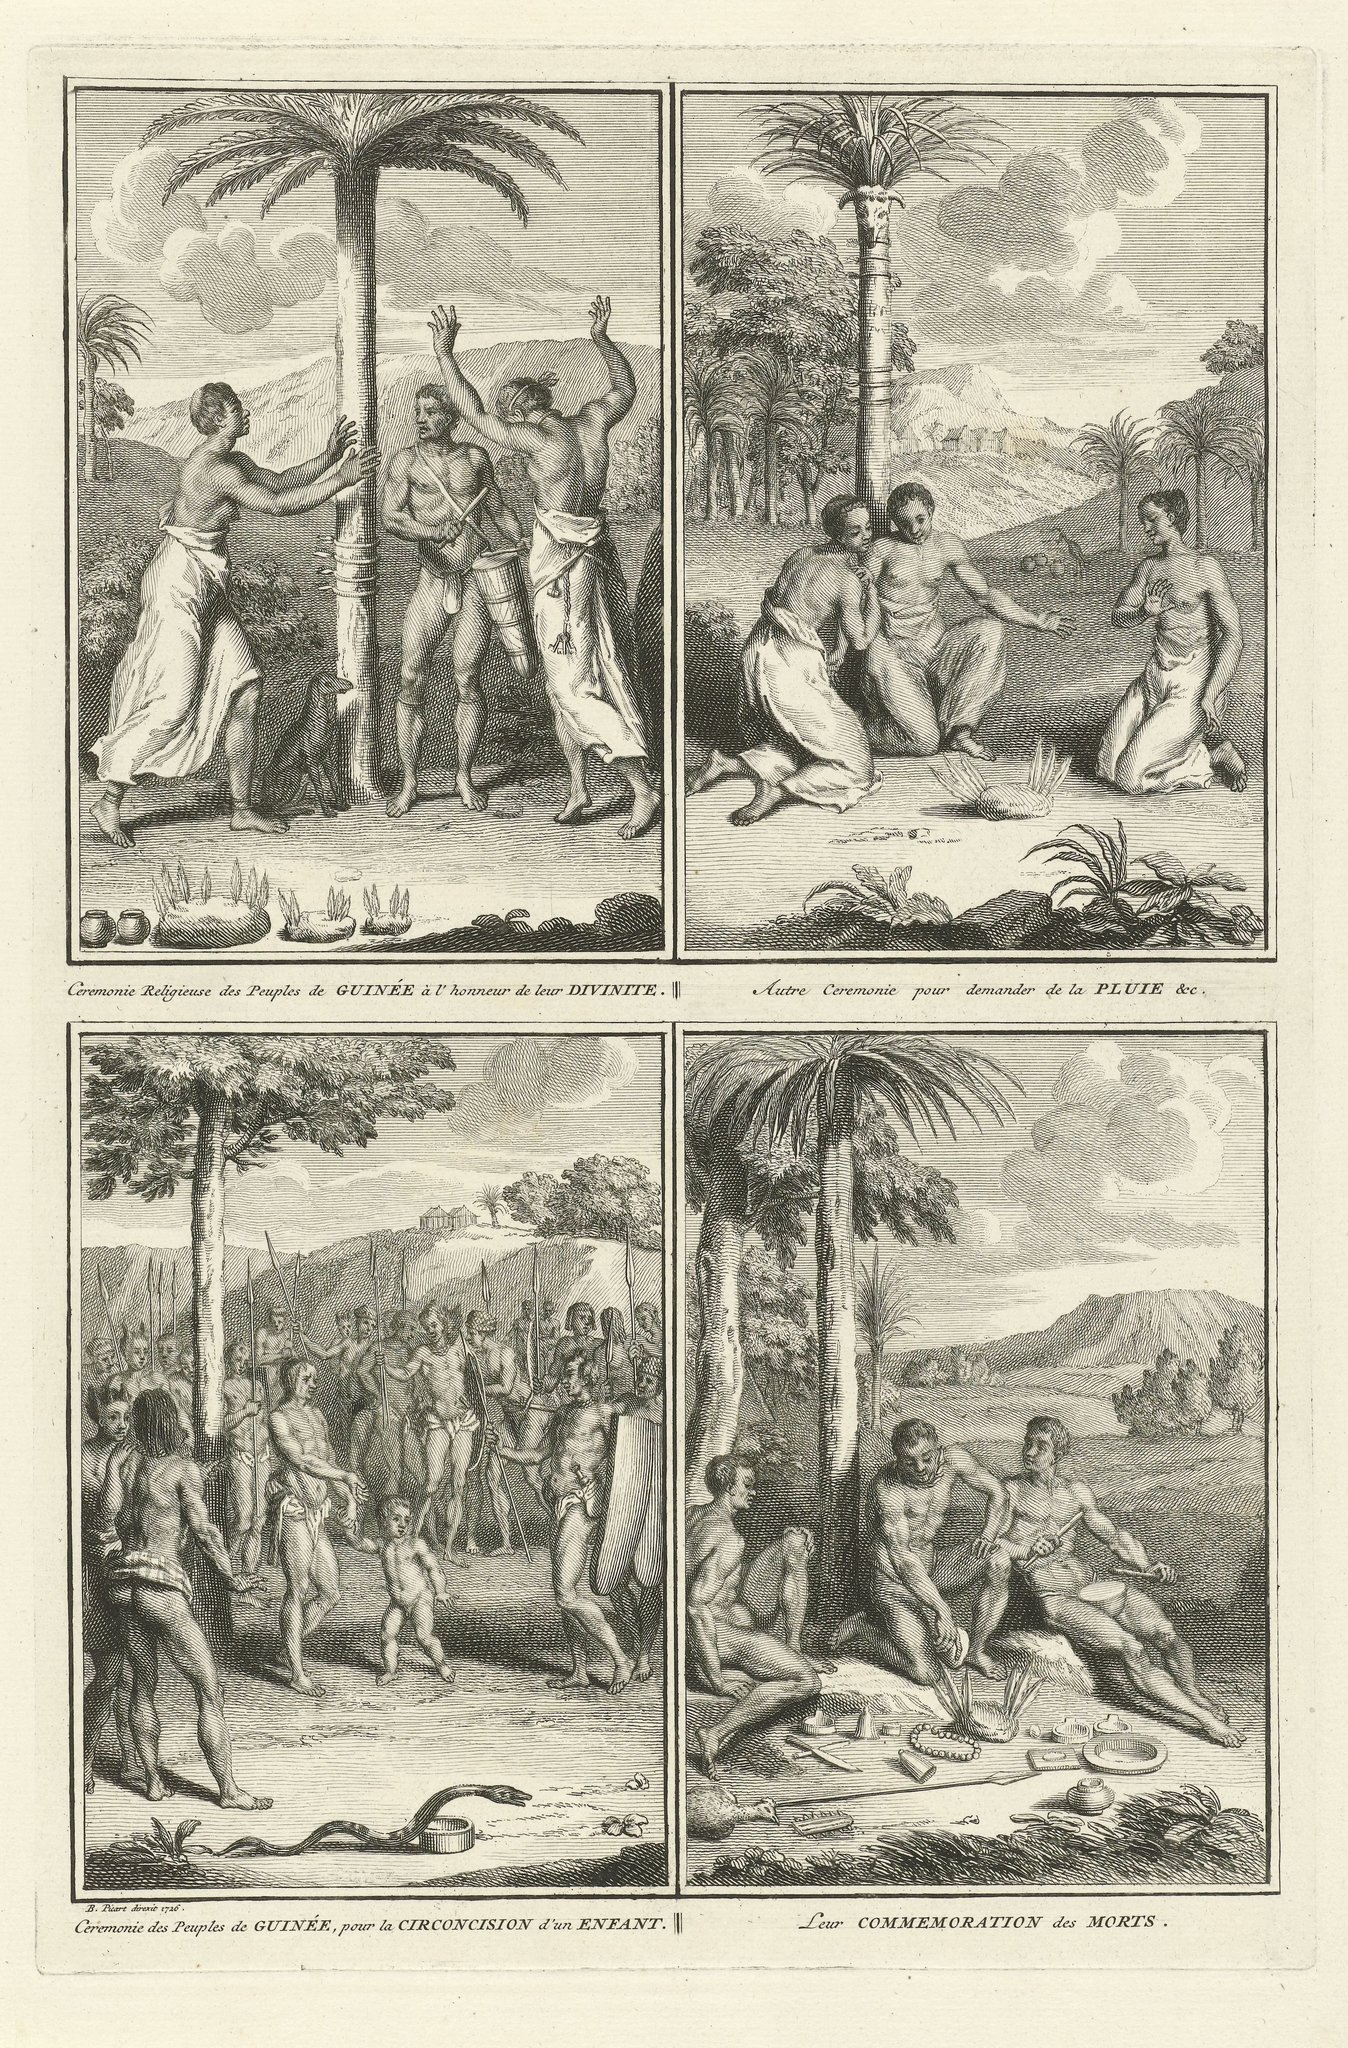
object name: book illustration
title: Rituelen van inwoners uit Guinea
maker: bernard picart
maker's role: draughtsman, print maker, publisher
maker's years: 1673-1733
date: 1726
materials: paper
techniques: engraving, etching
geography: amsterdam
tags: making music and dancing ~ african tribal religions, ritual practices ~ african tribal religions, circumcision as ritual practice ~ infancy (non-christian religions)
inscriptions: collector's mark: Lugt 2228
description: Prent ook gebruikt in: Picart, Bernard. Naaukeurige beschryving der uitwendige godtsdienst-plichten, kerk-zeden en gewoontens van alle volkeren der waereldt, deel IV. [Vertaald in het Nederlands door] Moubach, Abraham. Den Haag, Amsterdam, Rotterdam: Rutgert Alberts, Hermannus Uytwerf, Jan Daniel Beman, Isaac van der Kloot, 1727-1738.